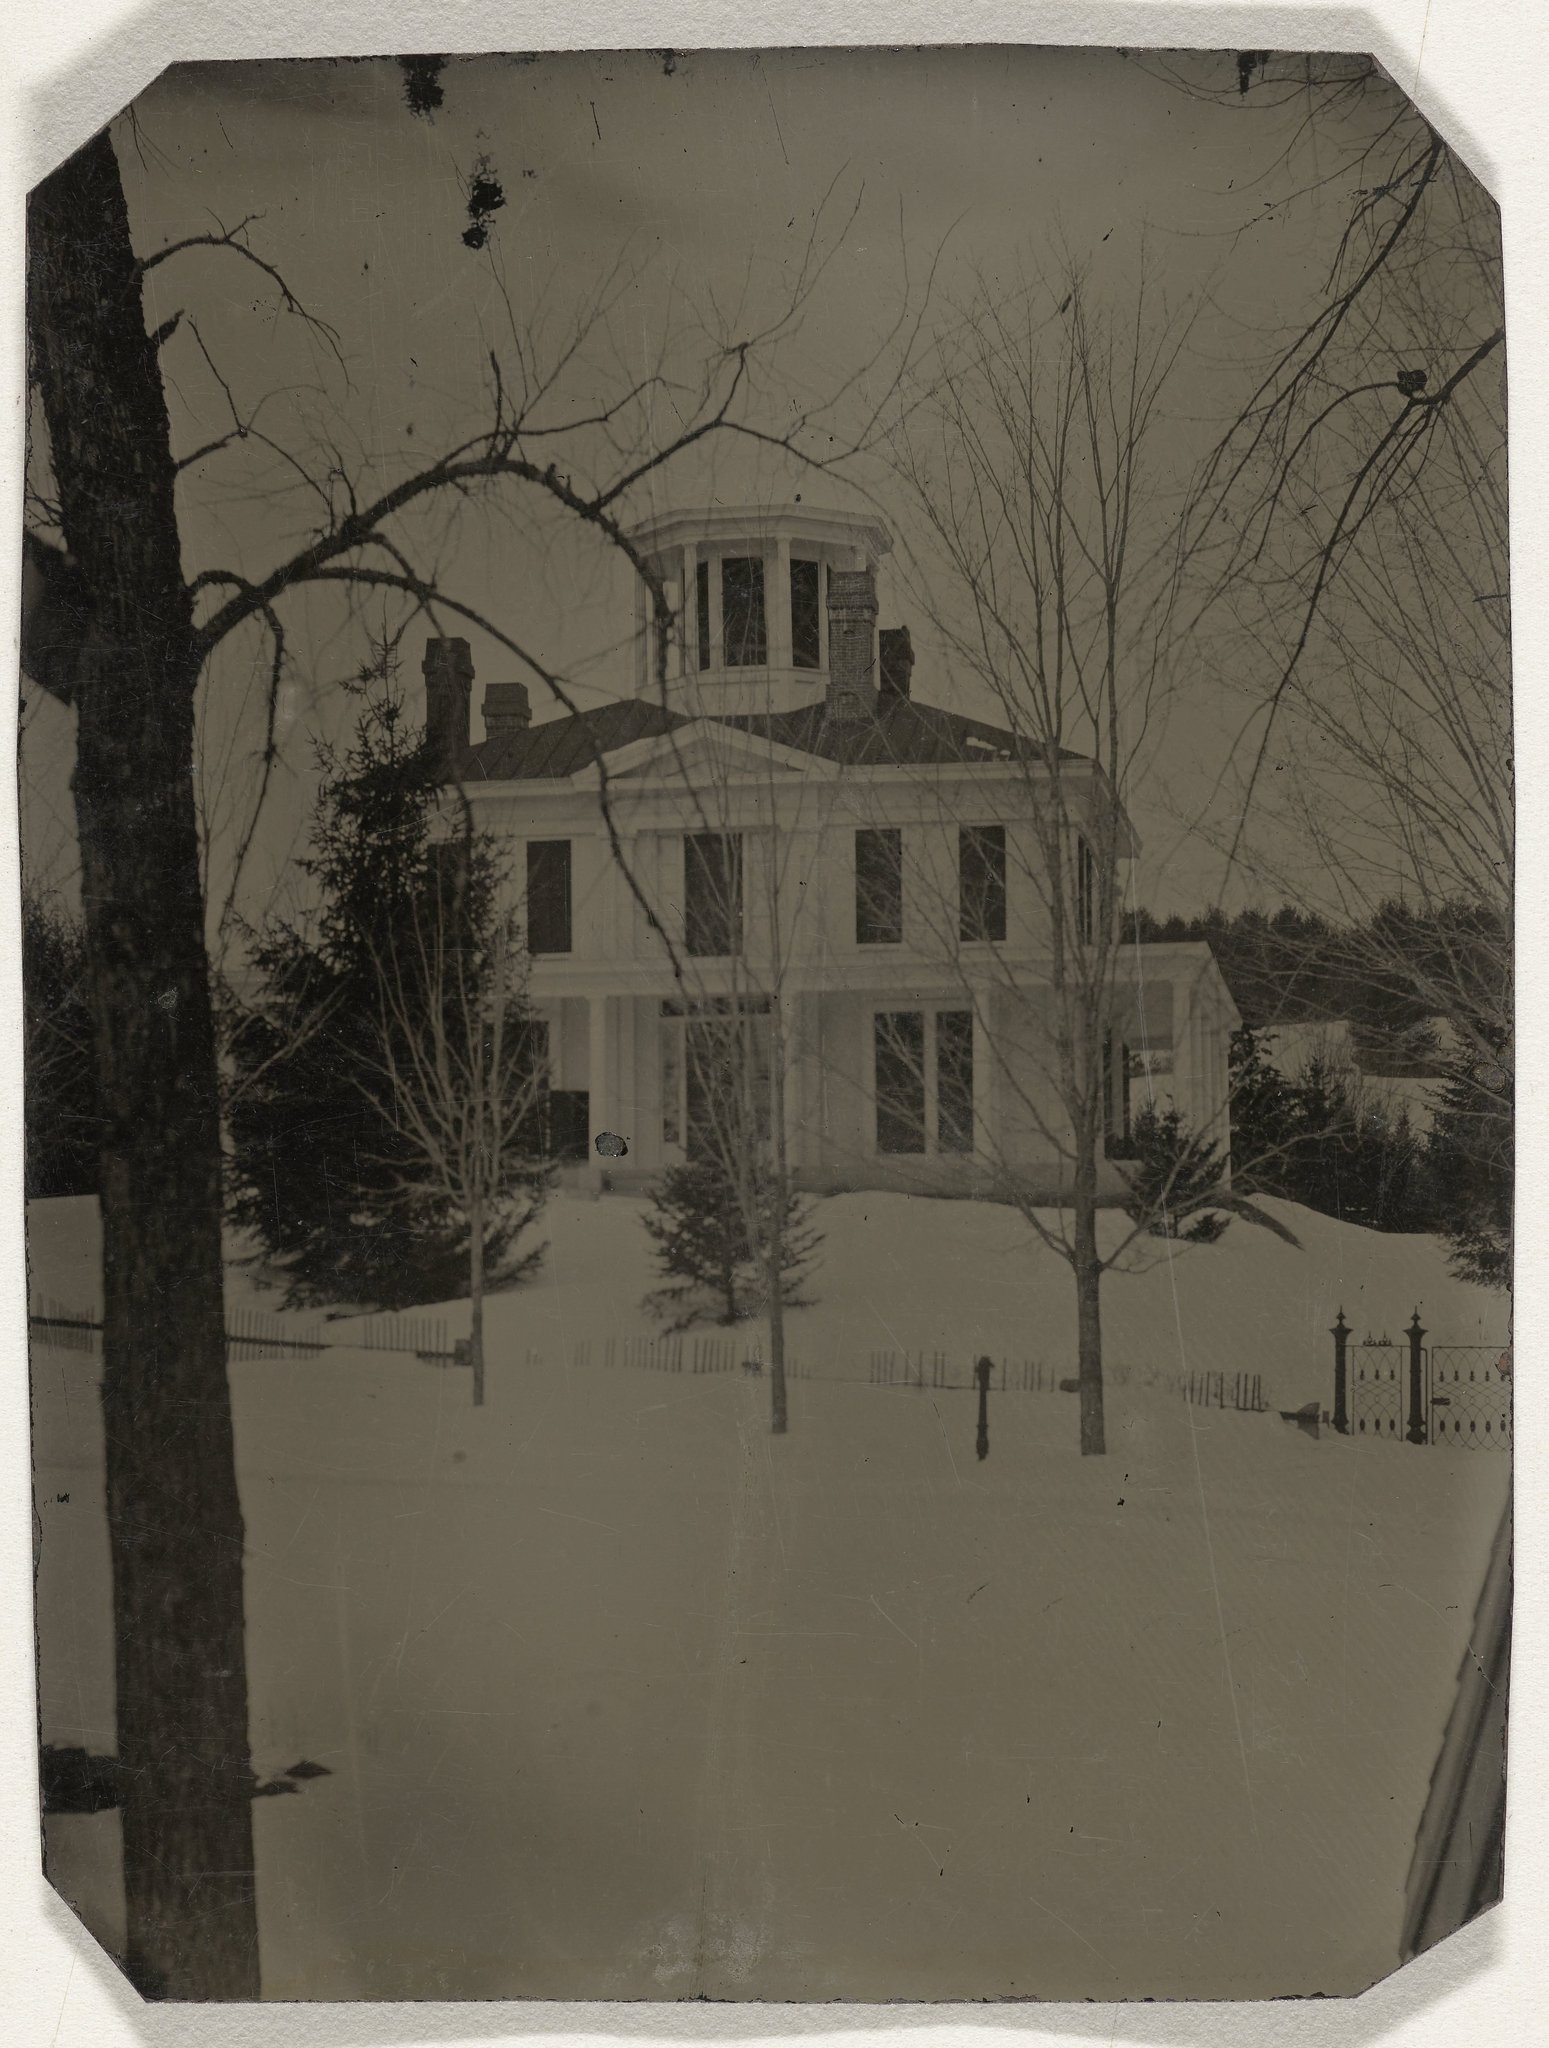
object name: photograph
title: Gezicht op een houten huis (met torentje of "widow's walk"of "roofwalk") in de sneeuw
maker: Anonymous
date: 1870-1900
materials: metal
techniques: ferrotyping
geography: united states